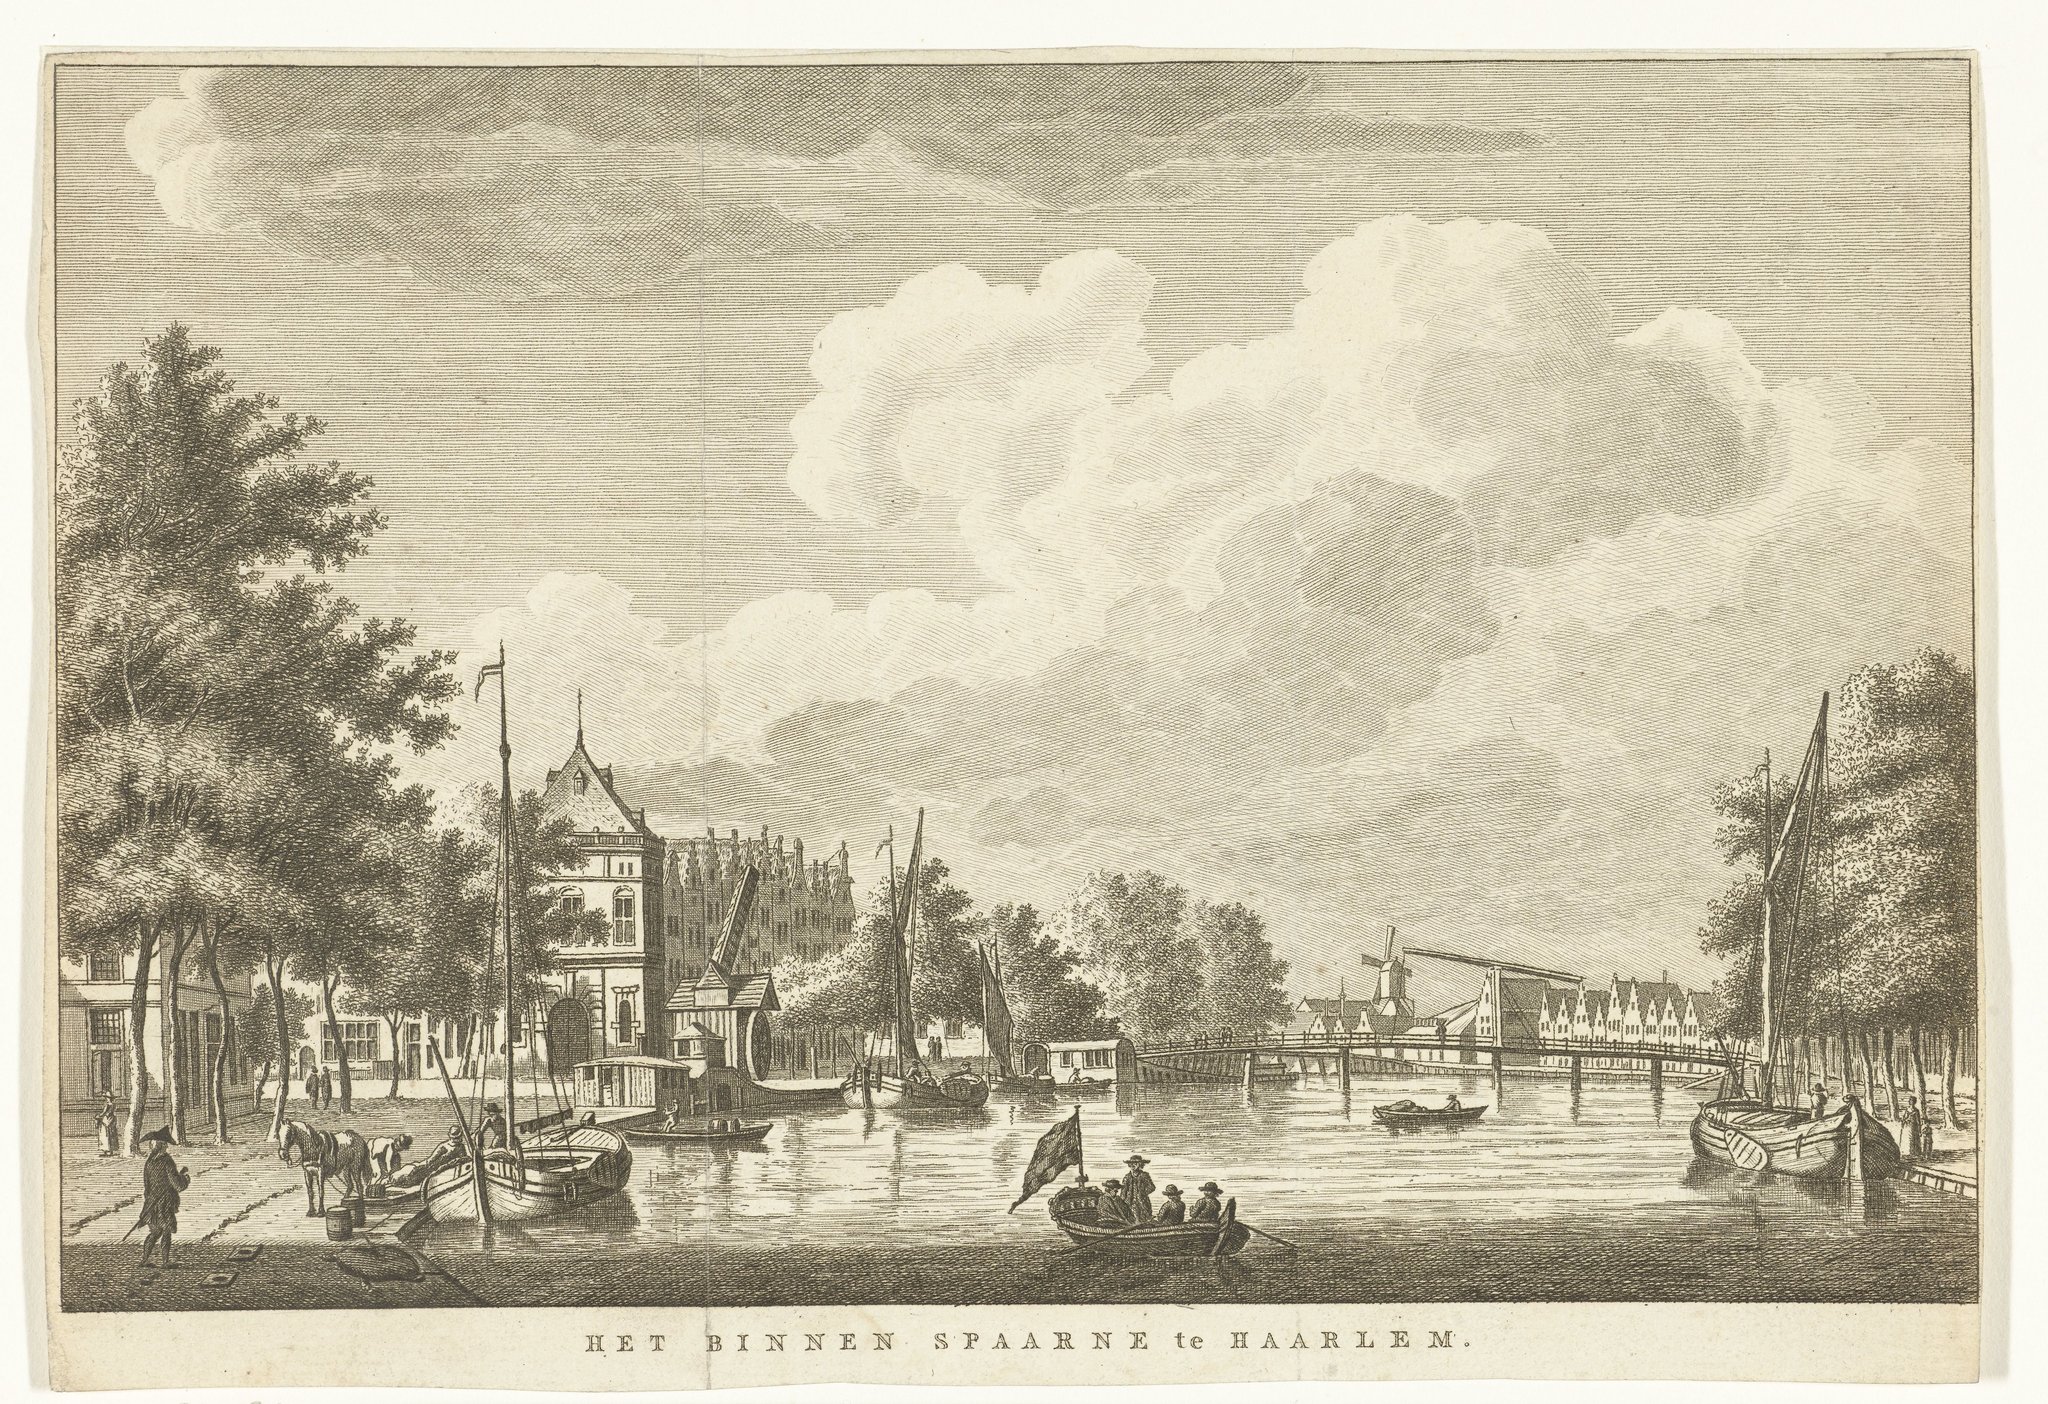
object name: print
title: Het Binnen Spaarne te Haarlem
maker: carel frederik bendorp (i)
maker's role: print maker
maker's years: 1736-1814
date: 1786-1792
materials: paper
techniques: etching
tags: weigh-house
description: Prent uit: Vaderlandsche gezichten, of afbeeldingen van den tegenwoordigen staat der Vereenigde Nederlanden (…). Amsterdam: Hendrik Gartman, Willem Vermandel en Jan Willem Smit, 1786-1792. Uitgegeven in afleveringen met ieder een eigen bifolium en inhoudsopgave. Alle prenten in deze publicatie zijn gegraveerd door Carel Frederik Bendorp (I) en, in de meeste gevallen, gebaseerd op tekeningen van Jan Bulthuis.